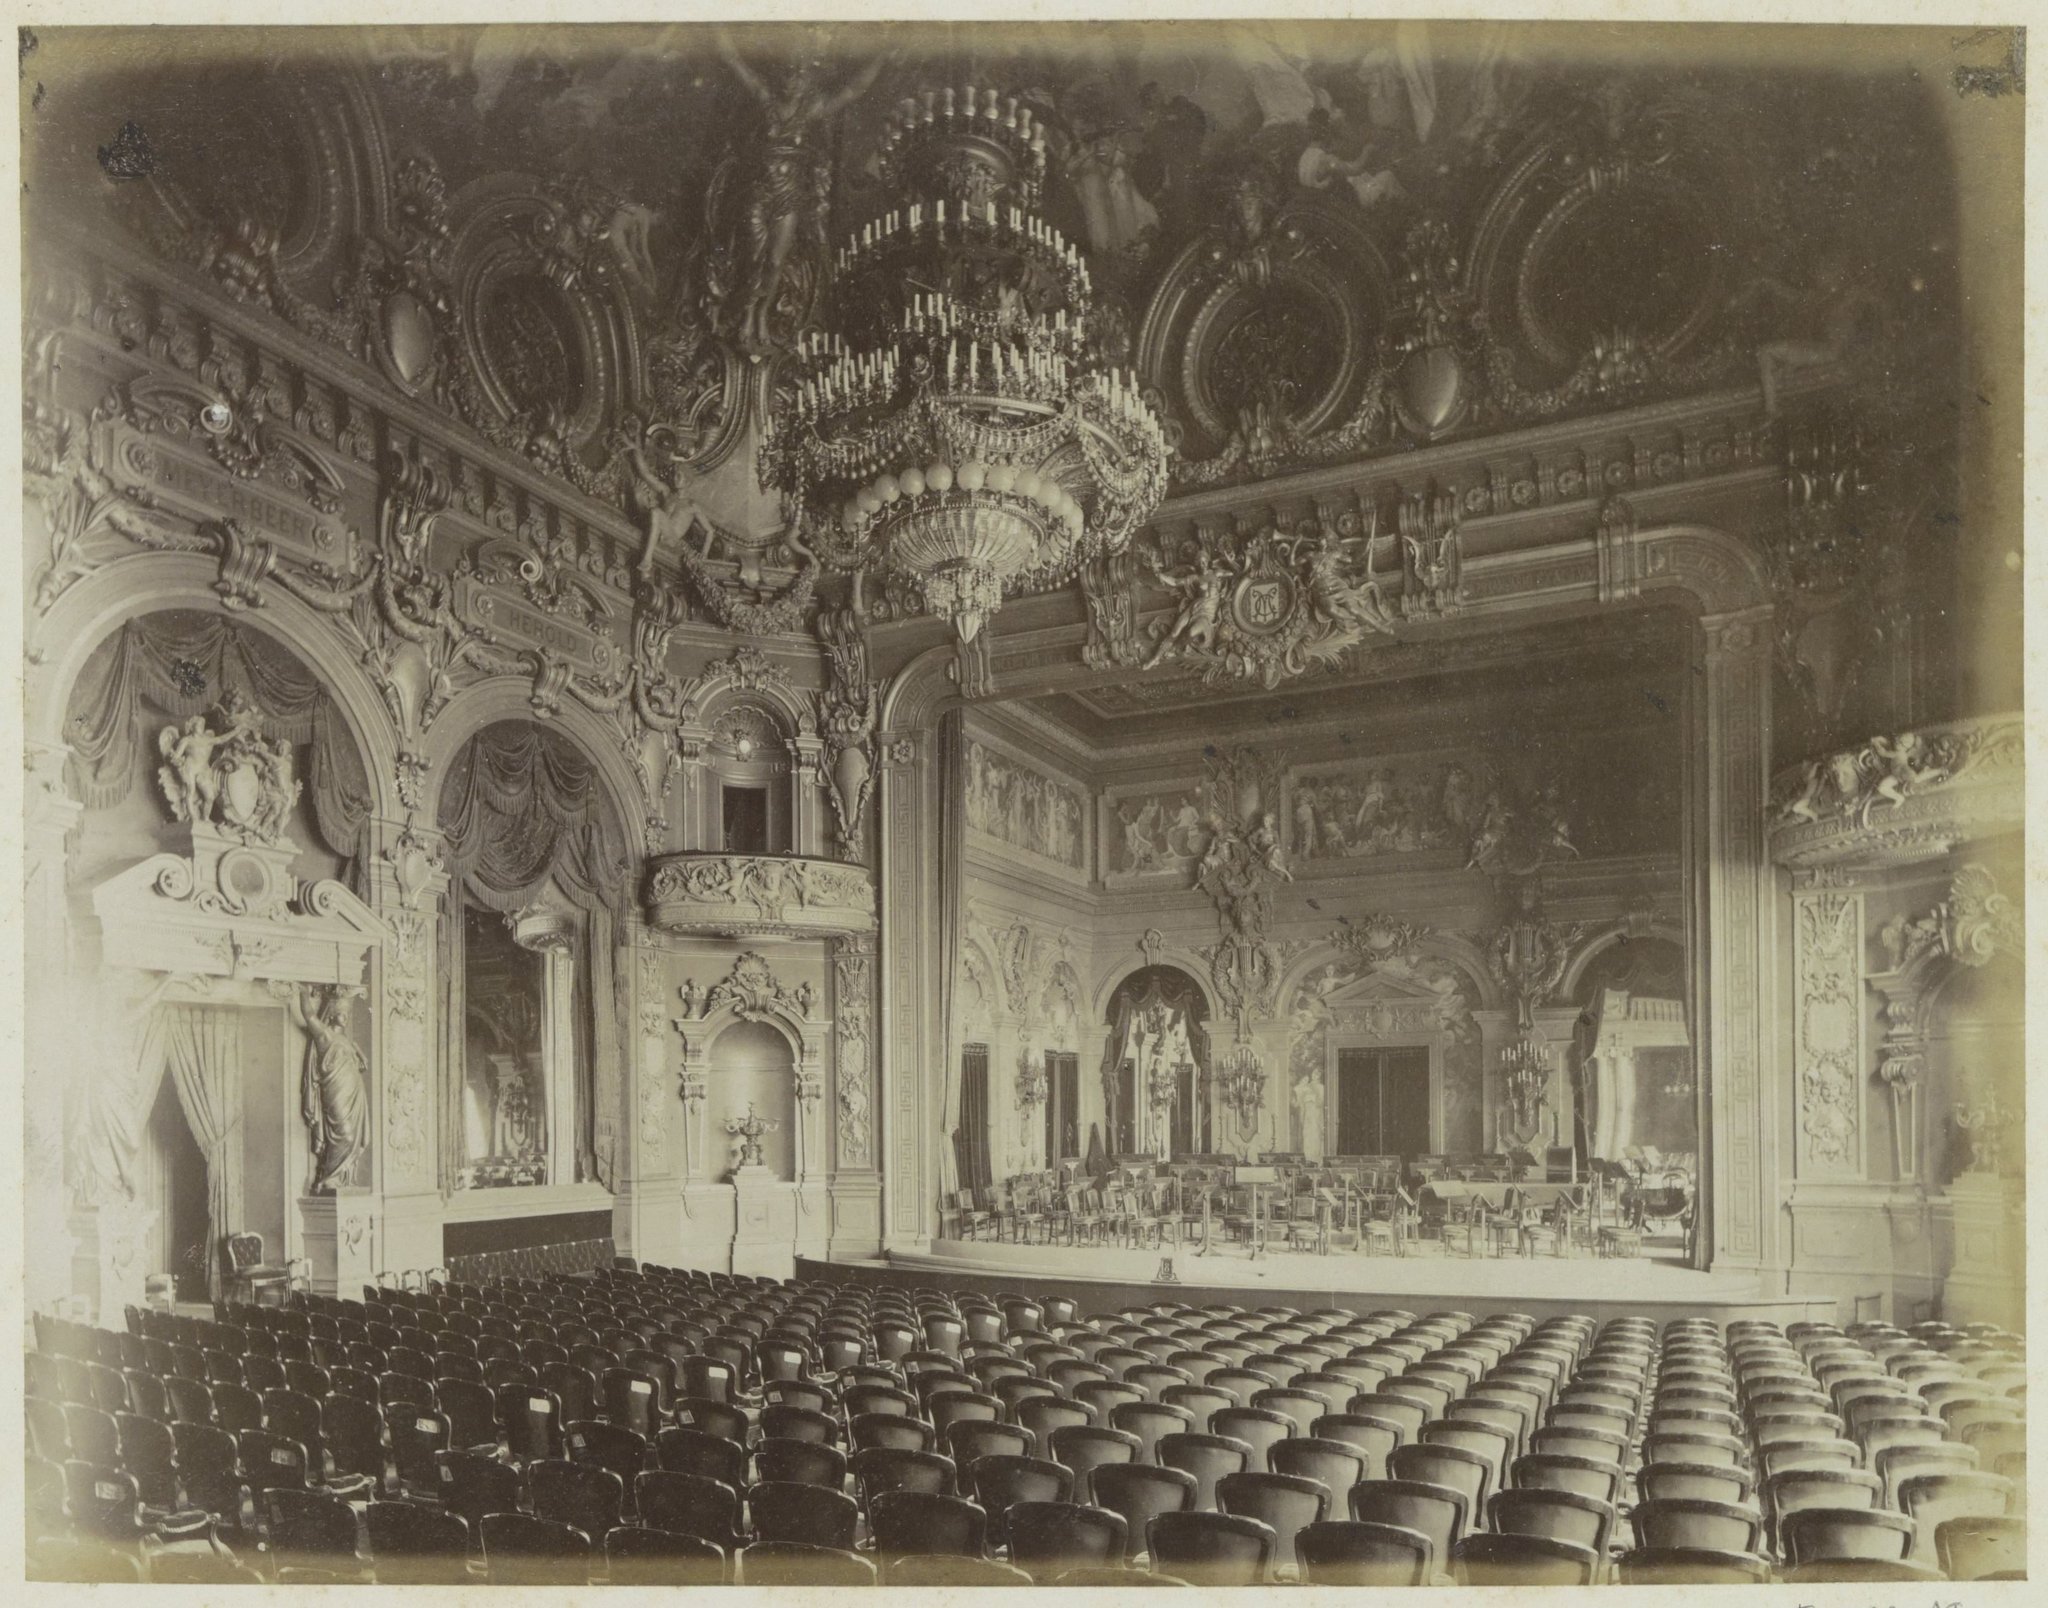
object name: photograph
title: Interieur van de operazaal (Salle Garnier) van het Monte Carlo Casino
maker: Anonymous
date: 1879-1900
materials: paper, photographic support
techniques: albumen print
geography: monaco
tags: concert hall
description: Onderdeel van Reisalbum met foto's van bezienswaardigheden in Italië en Frankrijk.